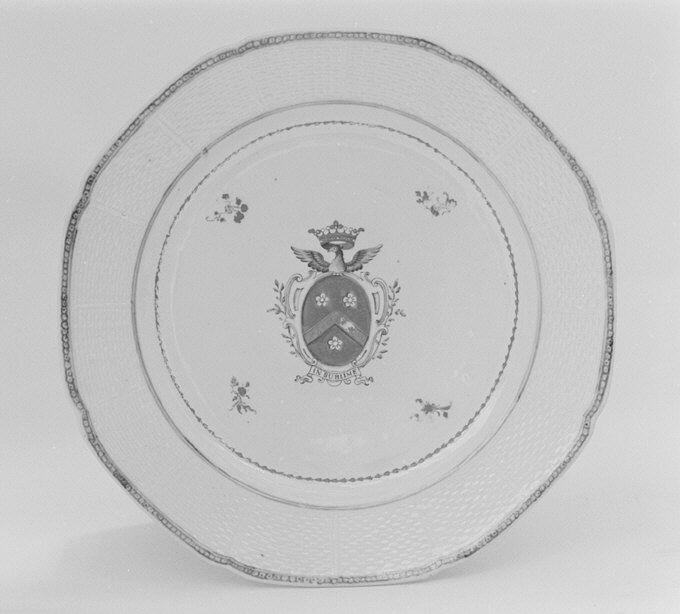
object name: plate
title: Plate (part of a service)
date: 1770-1785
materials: hard paste porcelain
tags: coat of arms